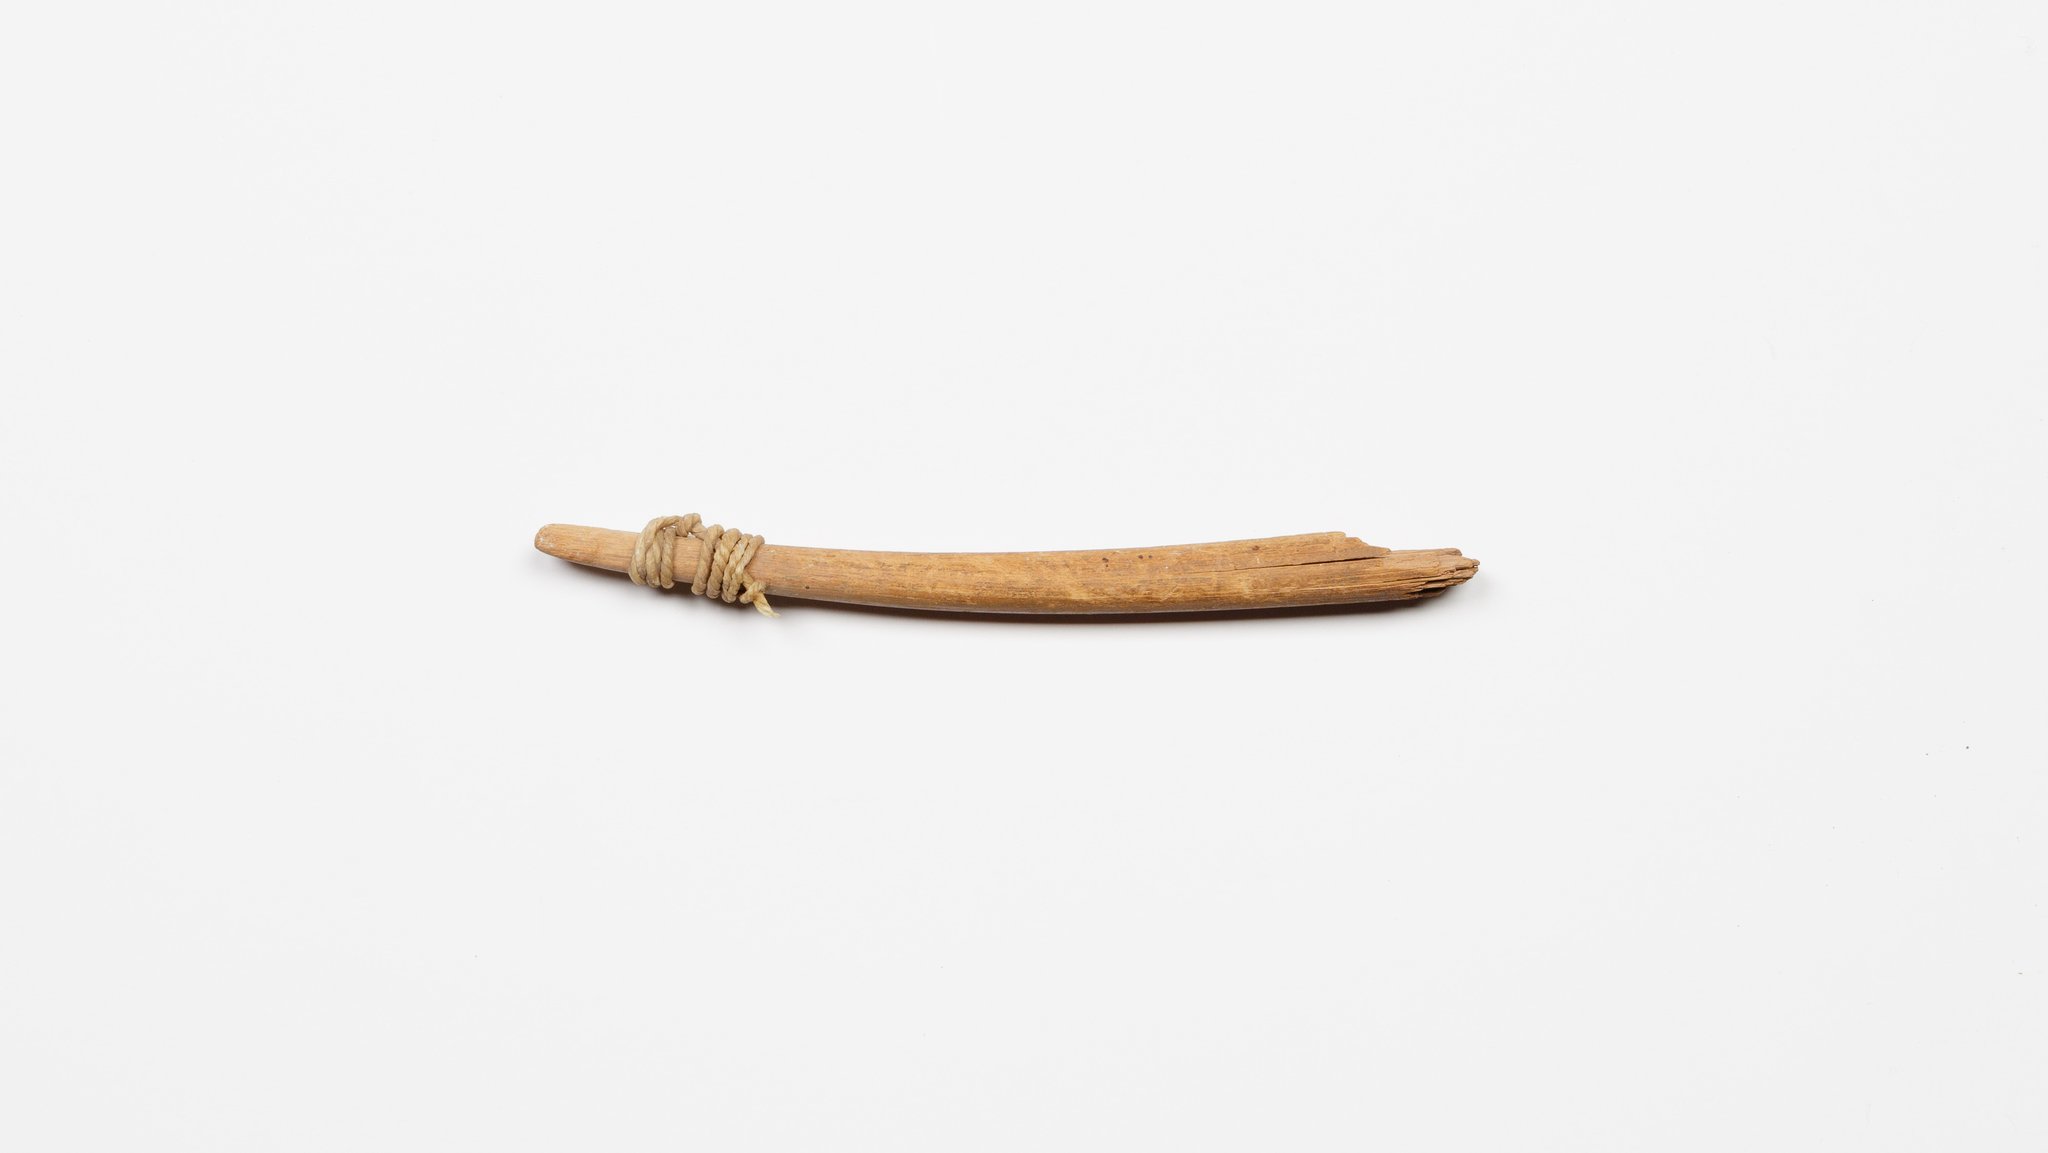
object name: bow end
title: End of bow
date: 2120-1981 BCE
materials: cord, wood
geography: egypt